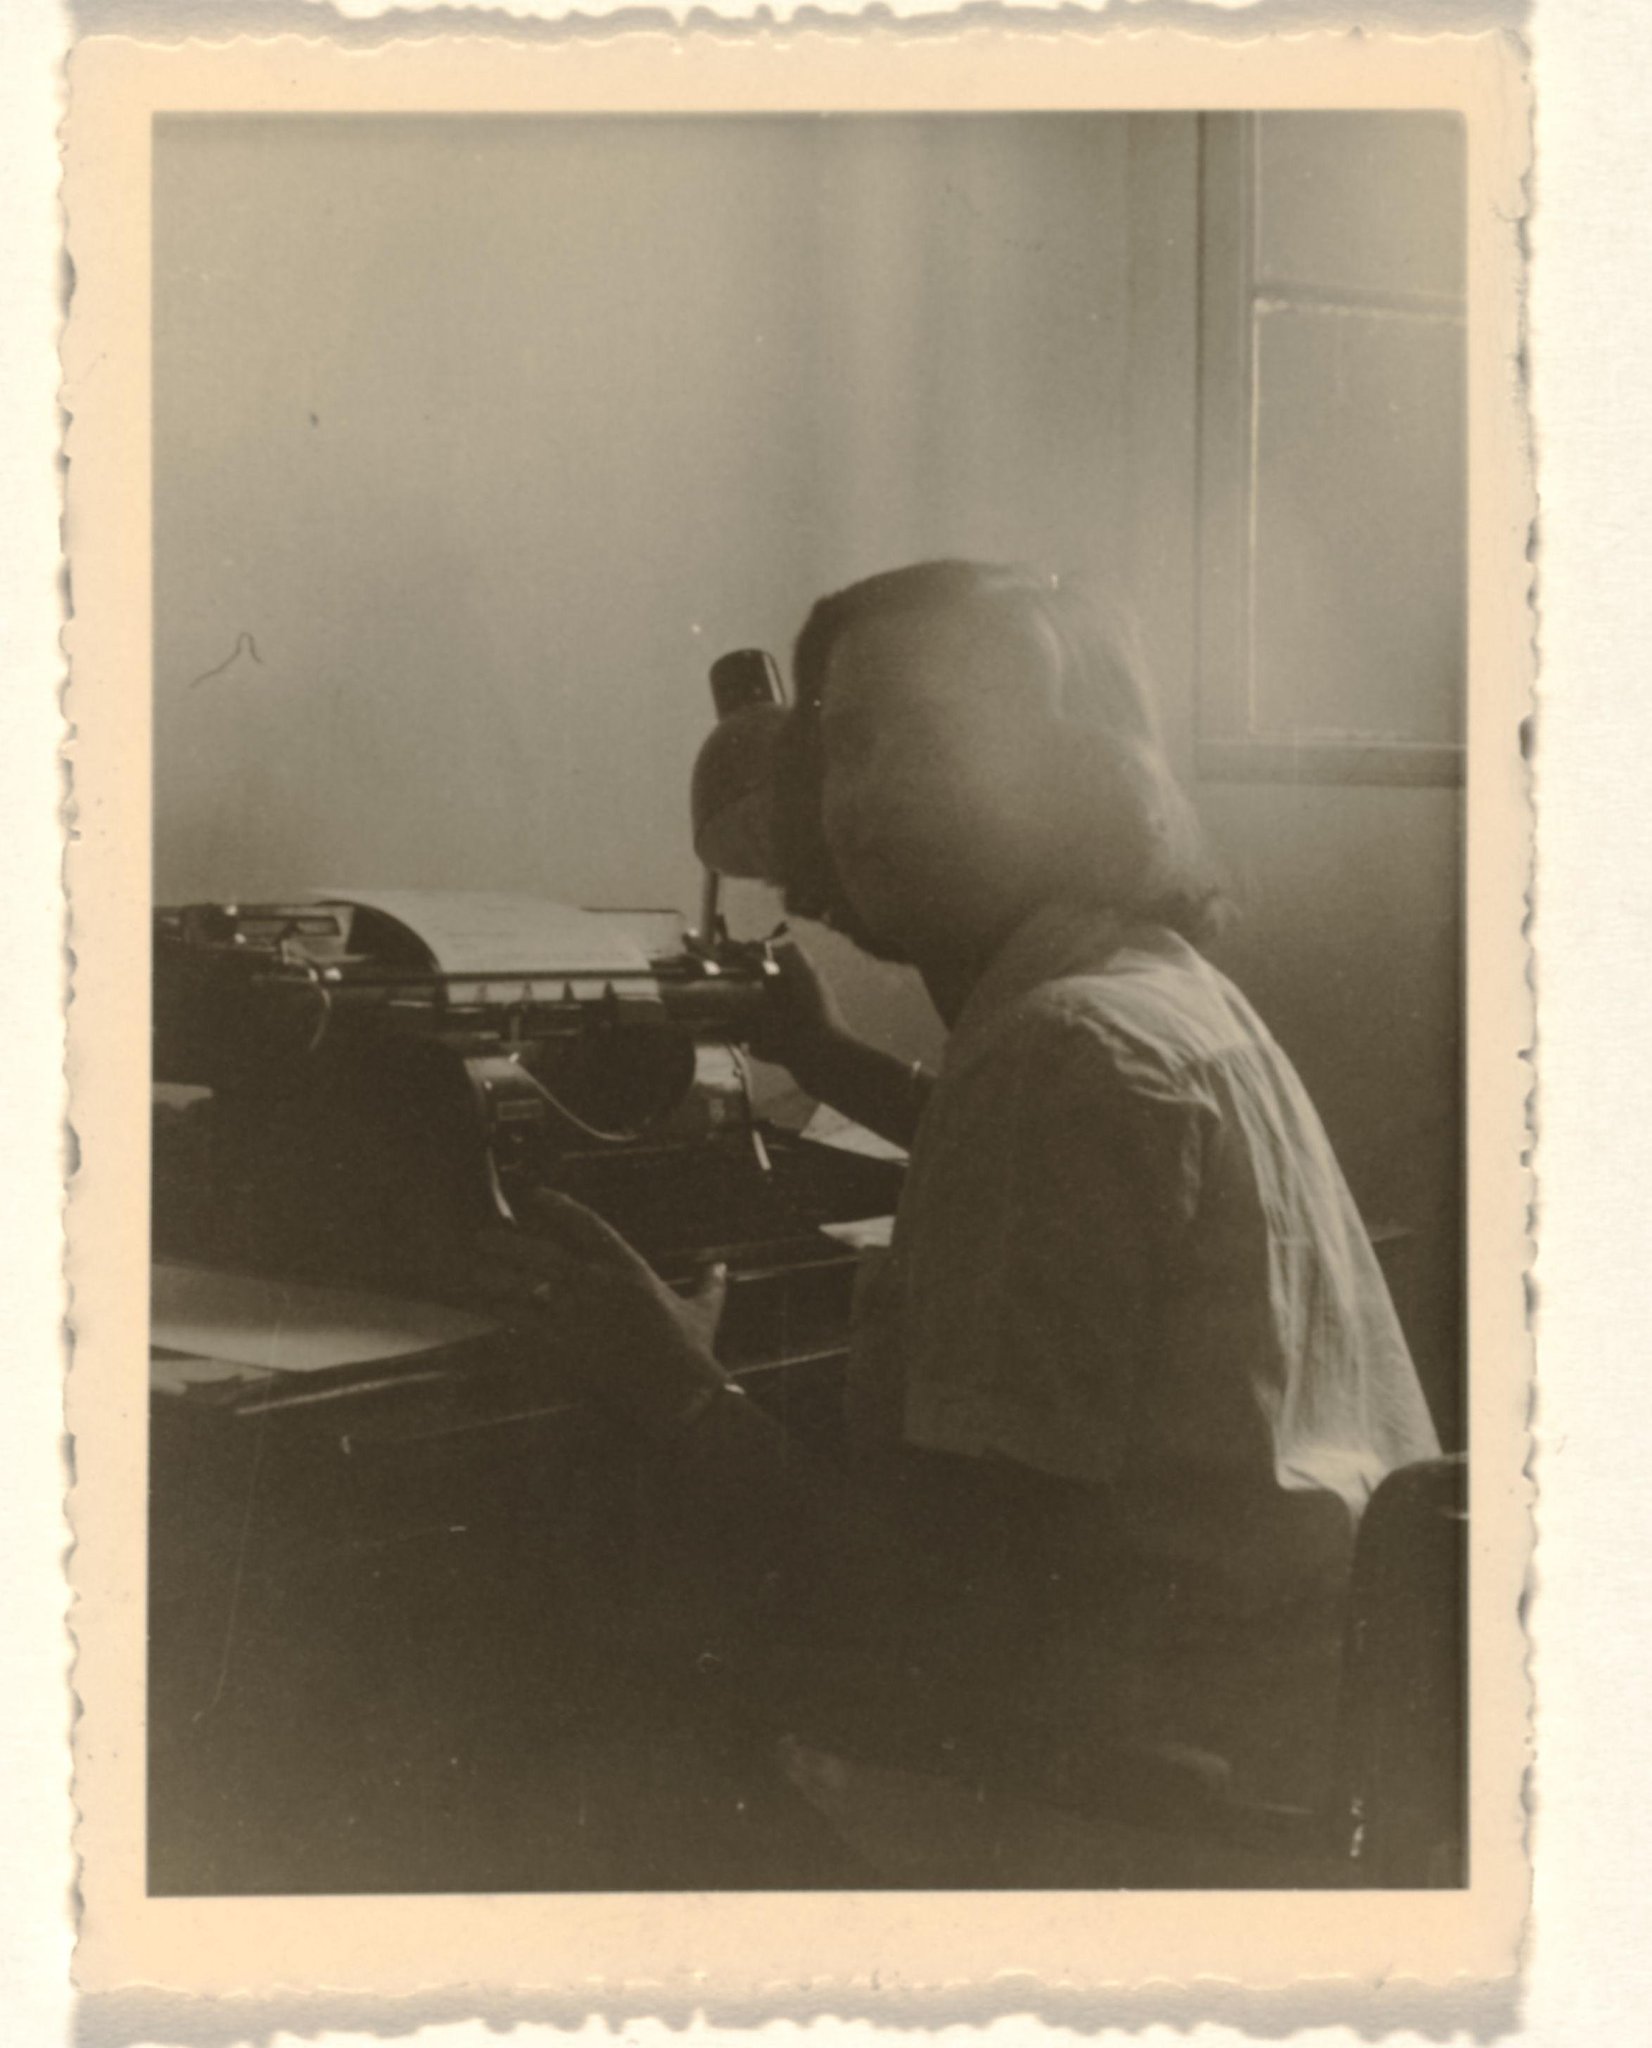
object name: photograph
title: Isabel Wachenheimer gezeten achter een schrijfmachine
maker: Anonymous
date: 1945-1963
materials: photographic support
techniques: gelatin silver print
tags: leiden, isabel wachenheimer-elon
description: Isabel Wachenheimer in licht hemd gezeten achter een schrijfmachine, kijkend naar de camera.